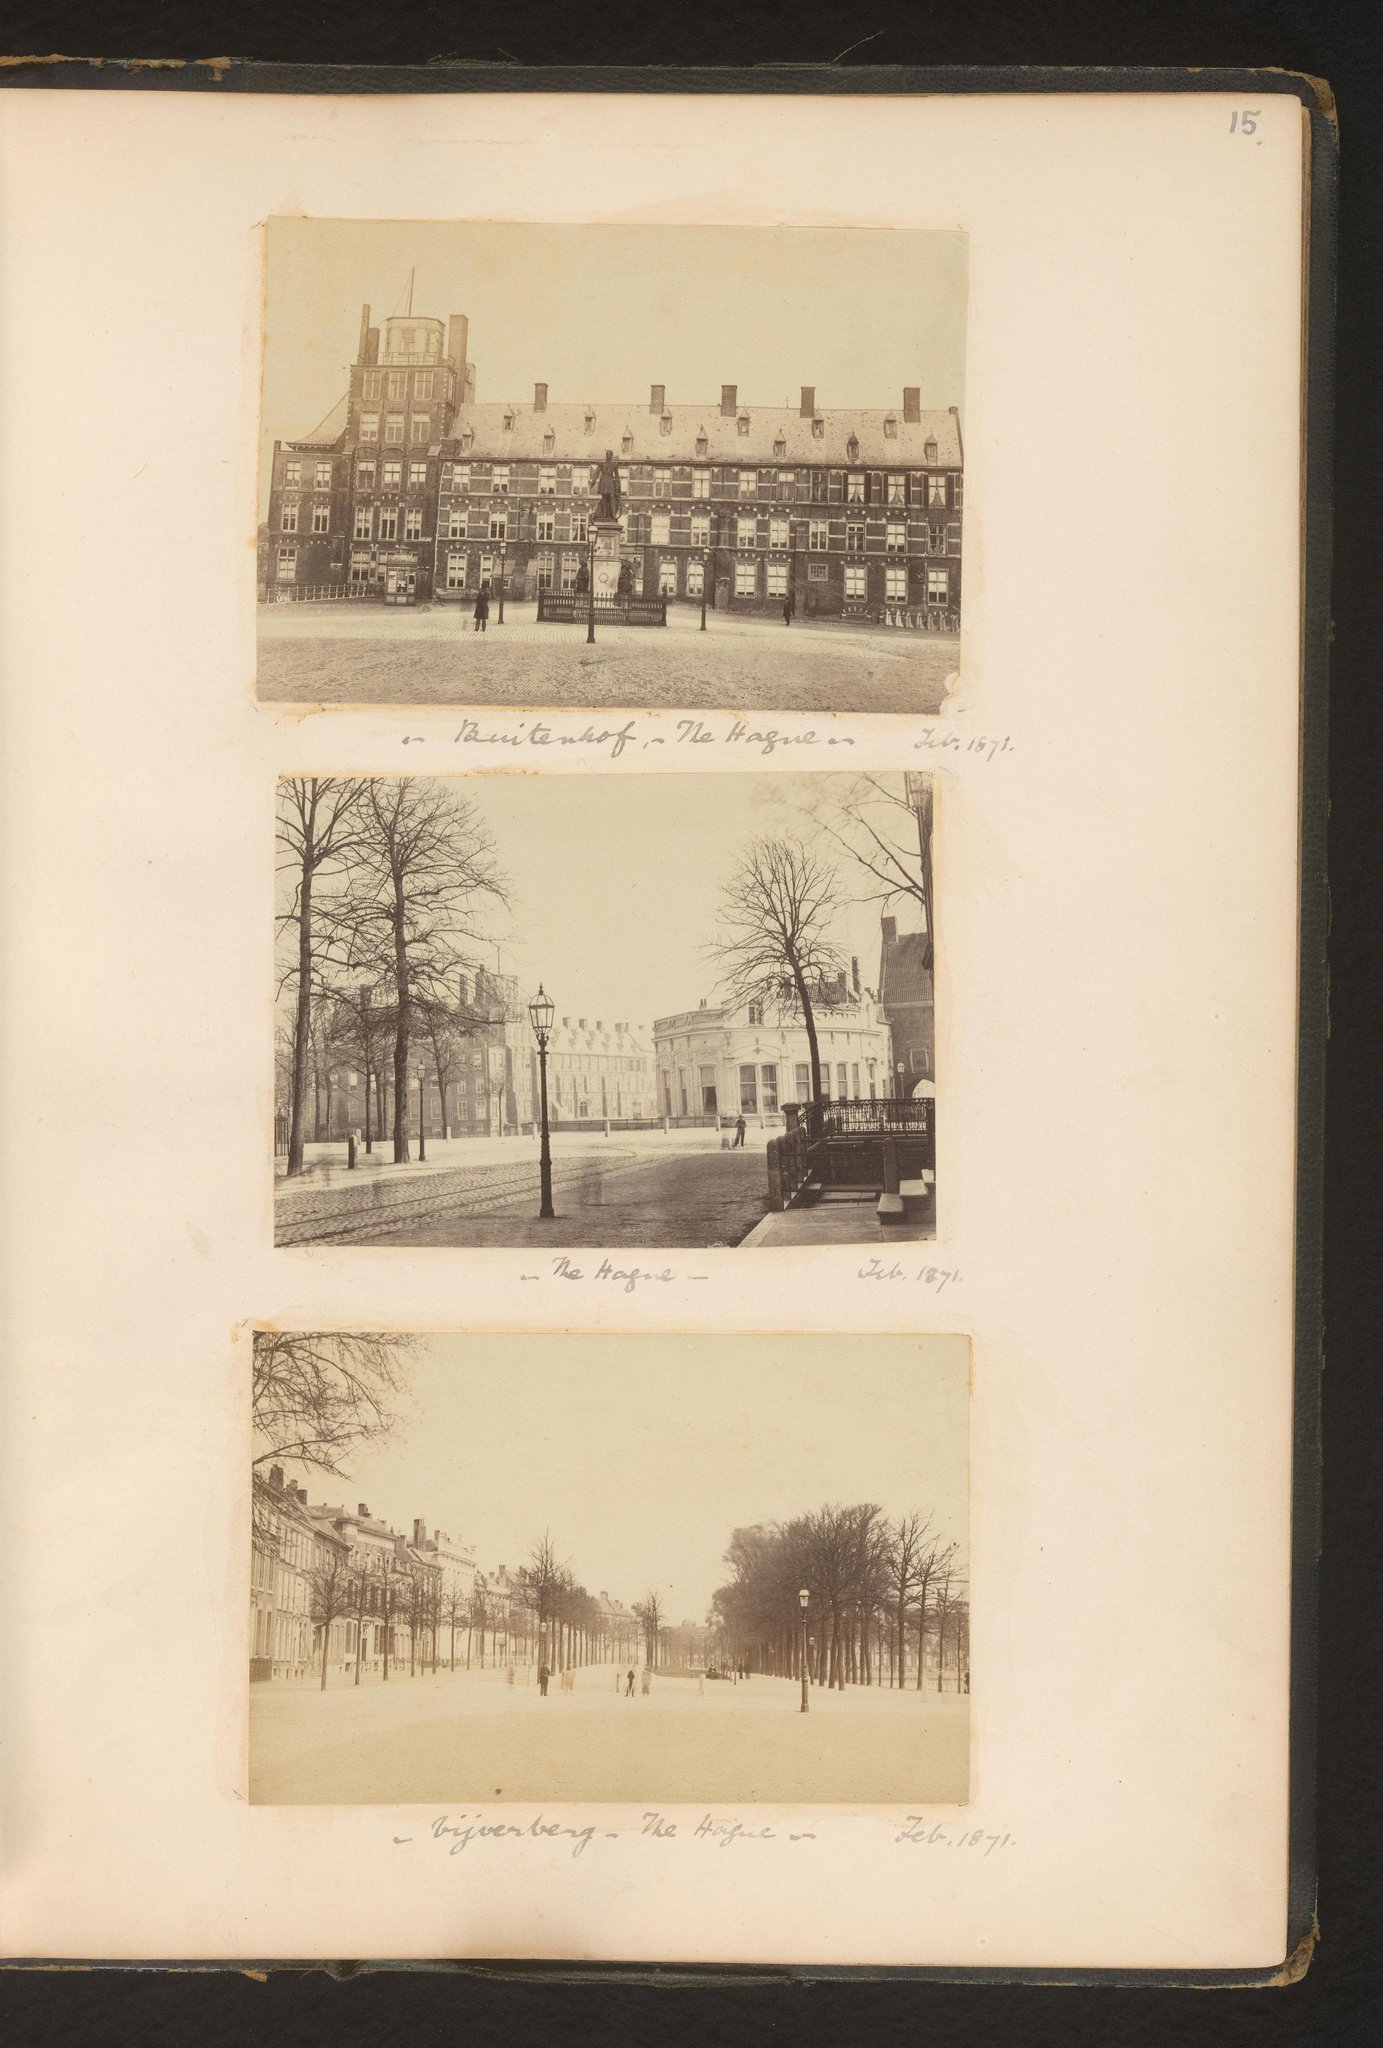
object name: photograph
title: Gezichten op Den Haag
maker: Anonymous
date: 1802-1871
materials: paper, photographic support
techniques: albumen print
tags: civic architecture; edifices; dwellings, street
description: Gezichten op het Buitenhof en de Korte Vijverberg. Deze pagina maakt deel uit van een album.